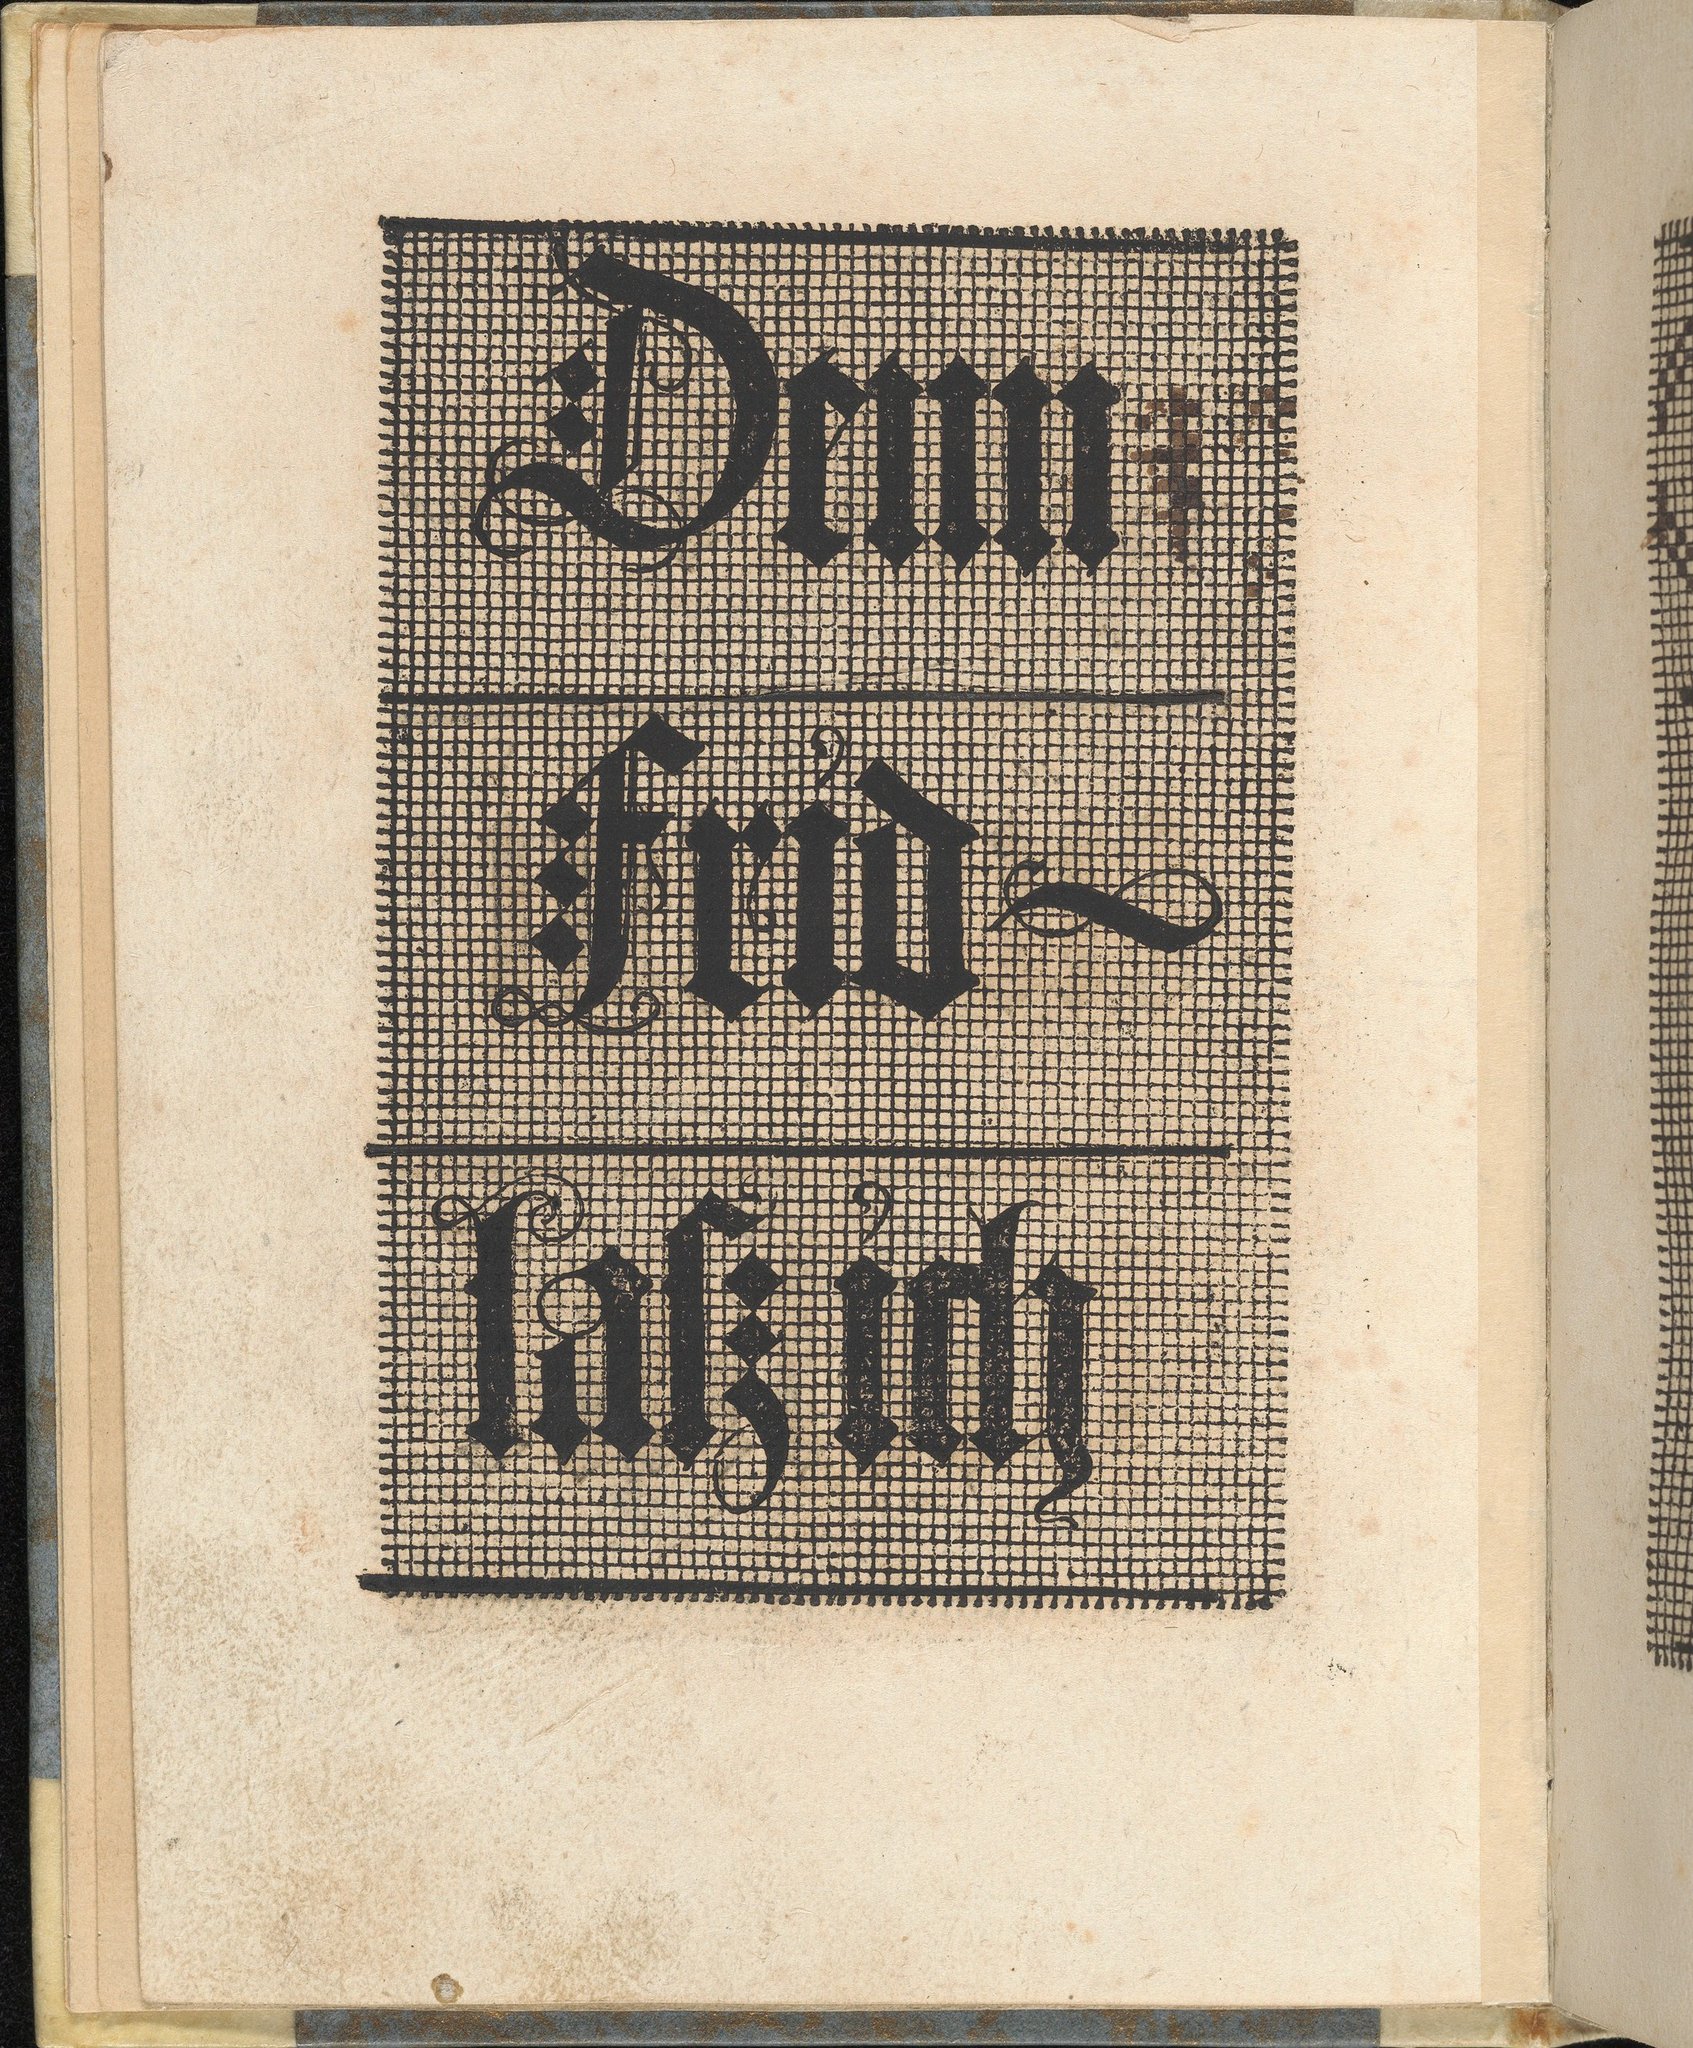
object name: book print ornament architecture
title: Ein ney Furmbüchlein, Page 5, verso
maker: johann schönsperger the younger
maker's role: publisher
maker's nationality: german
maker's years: 1490-1550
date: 1525-1529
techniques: woodcut